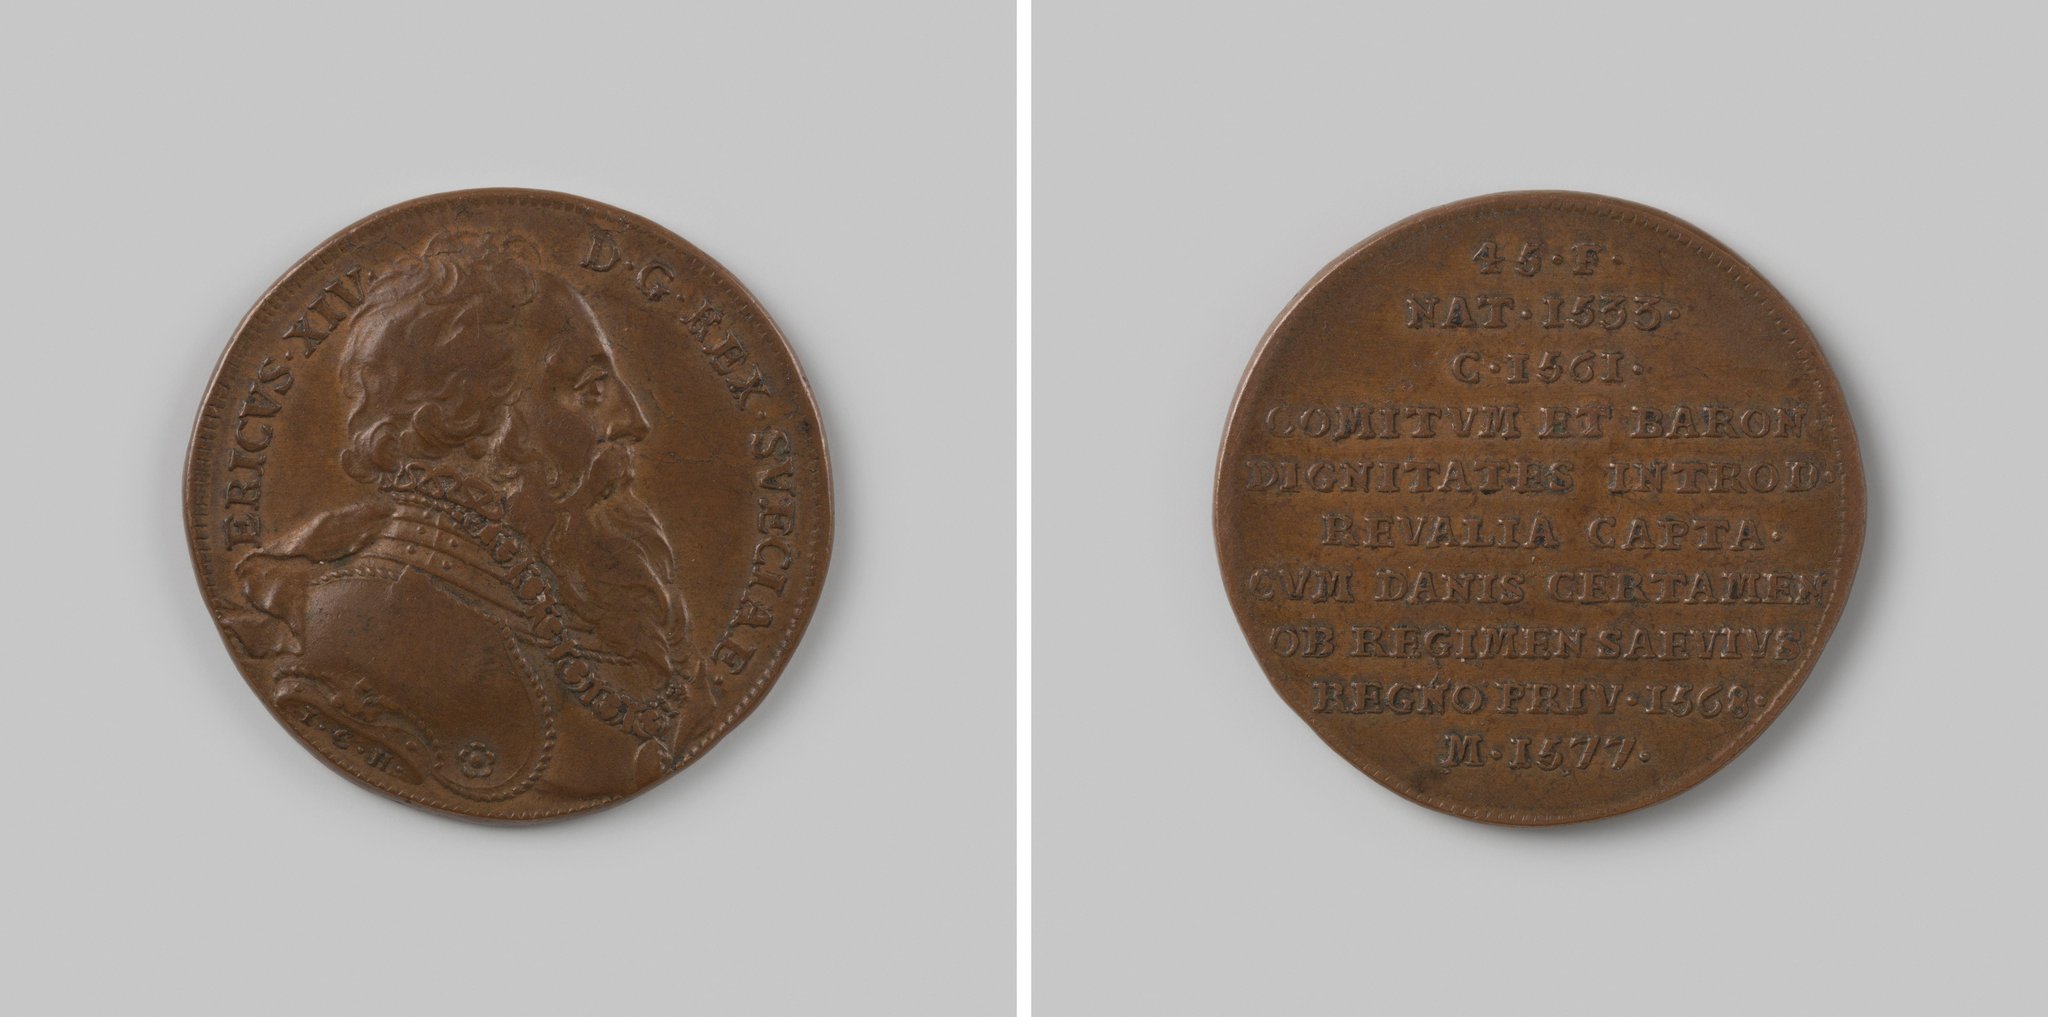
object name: history medal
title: Overlijden van Koning Erik XIV van Zweden 1577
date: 1577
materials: copper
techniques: striking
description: Koperen penning, op de voorzijde het borstbeeld van Erik XIV naar rechts met omschrift, op de keerzijde tien regels tekst.